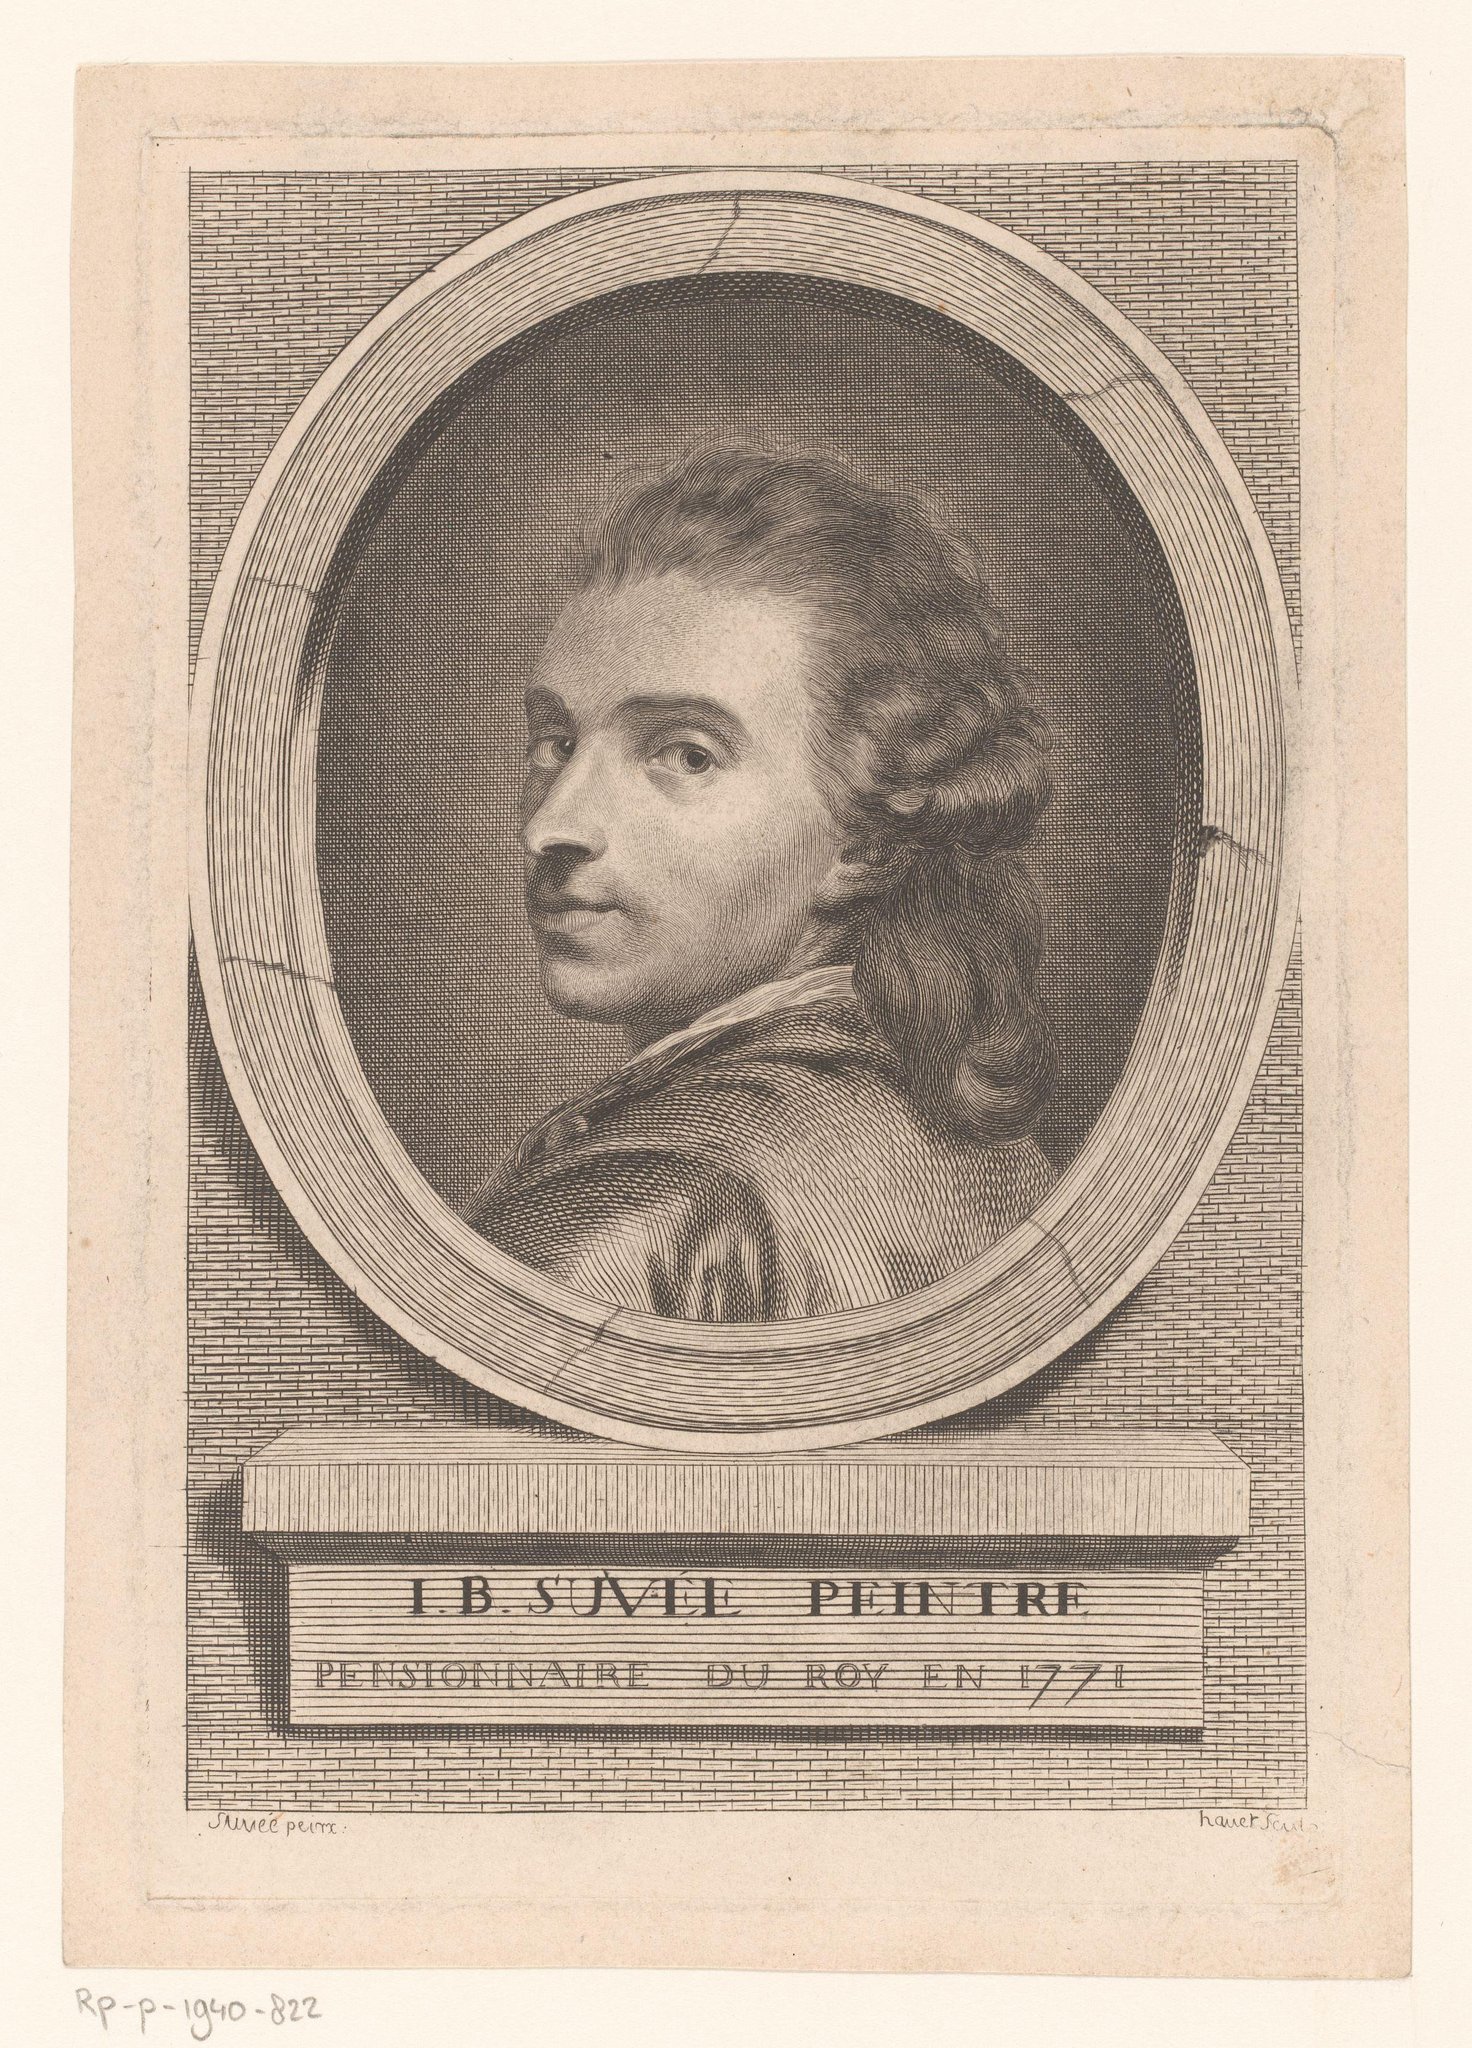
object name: print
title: Portret van Joseph-Benoît Suvée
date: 1771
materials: paper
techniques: engraving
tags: rome, historical persons, portrait, self-portrait of painter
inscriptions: collector's mark: Lugt 2760, collector's mark: Lugt 2228